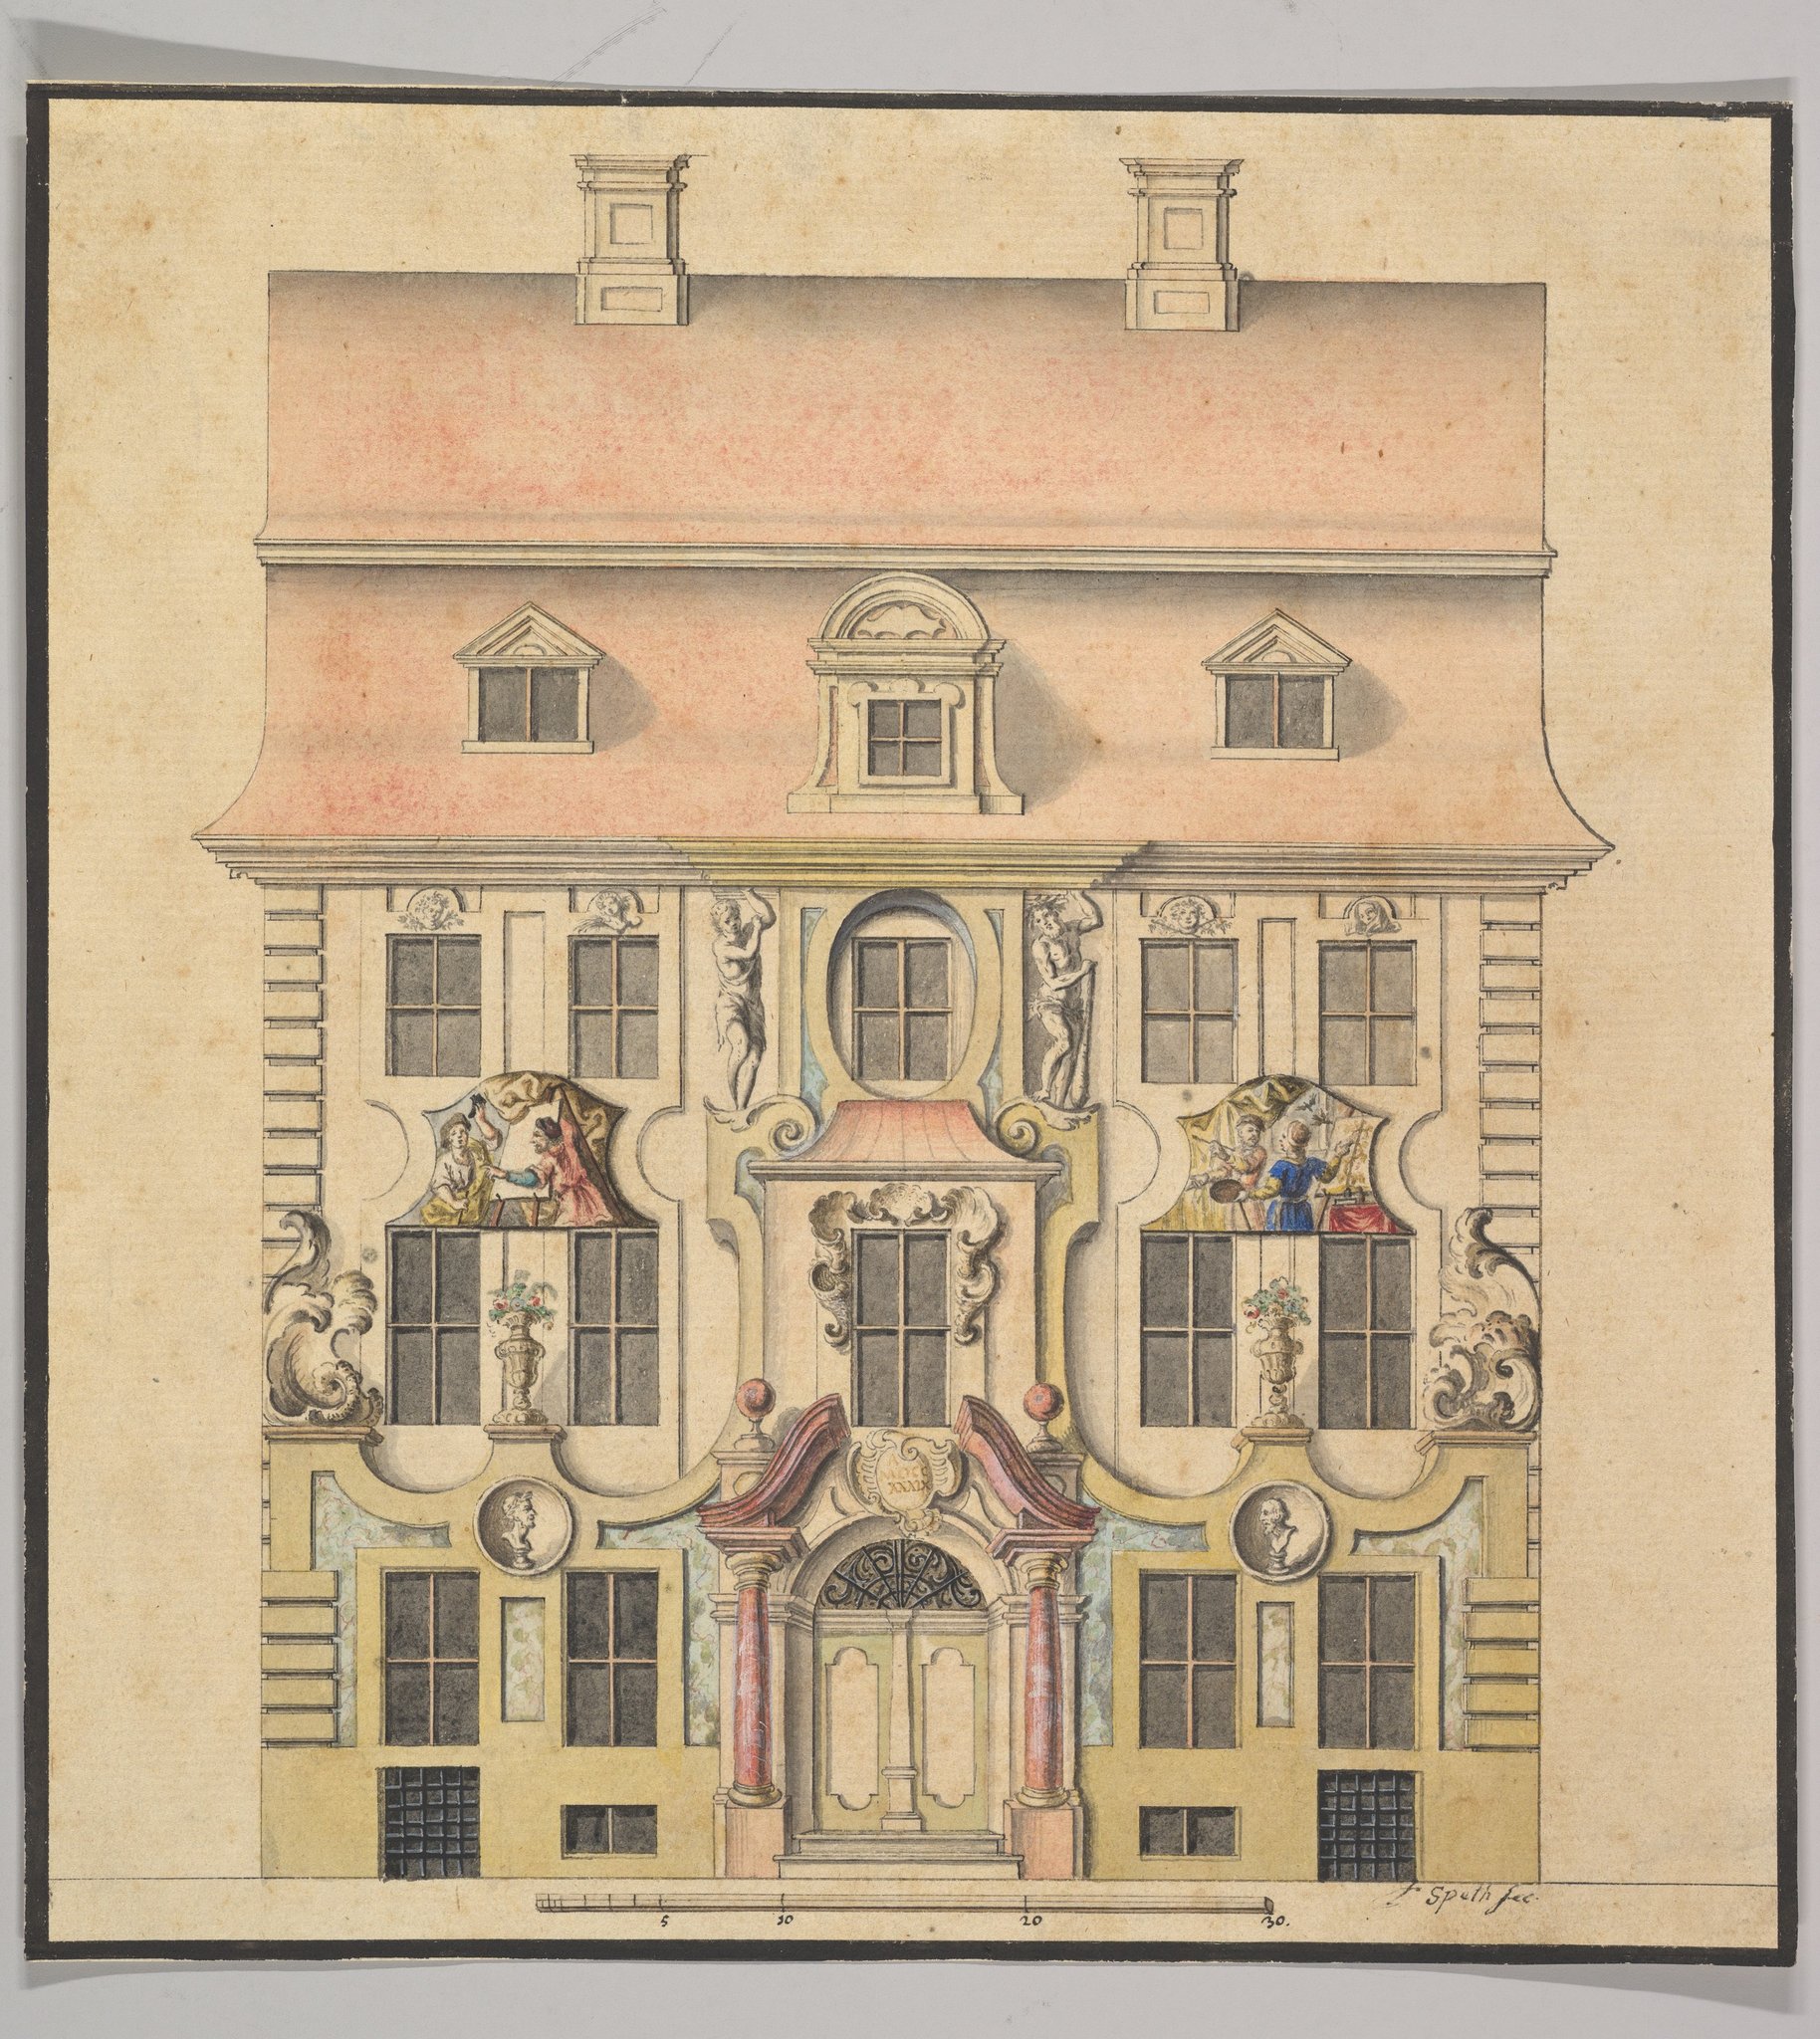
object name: collection ornament architecture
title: Architectural Design for a Façade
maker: ferenc (franz) speth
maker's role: artist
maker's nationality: hungarian or austrian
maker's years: 1739-1769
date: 1739-1769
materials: ink, watercolor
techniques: pen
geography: germany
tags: architecture,buildings